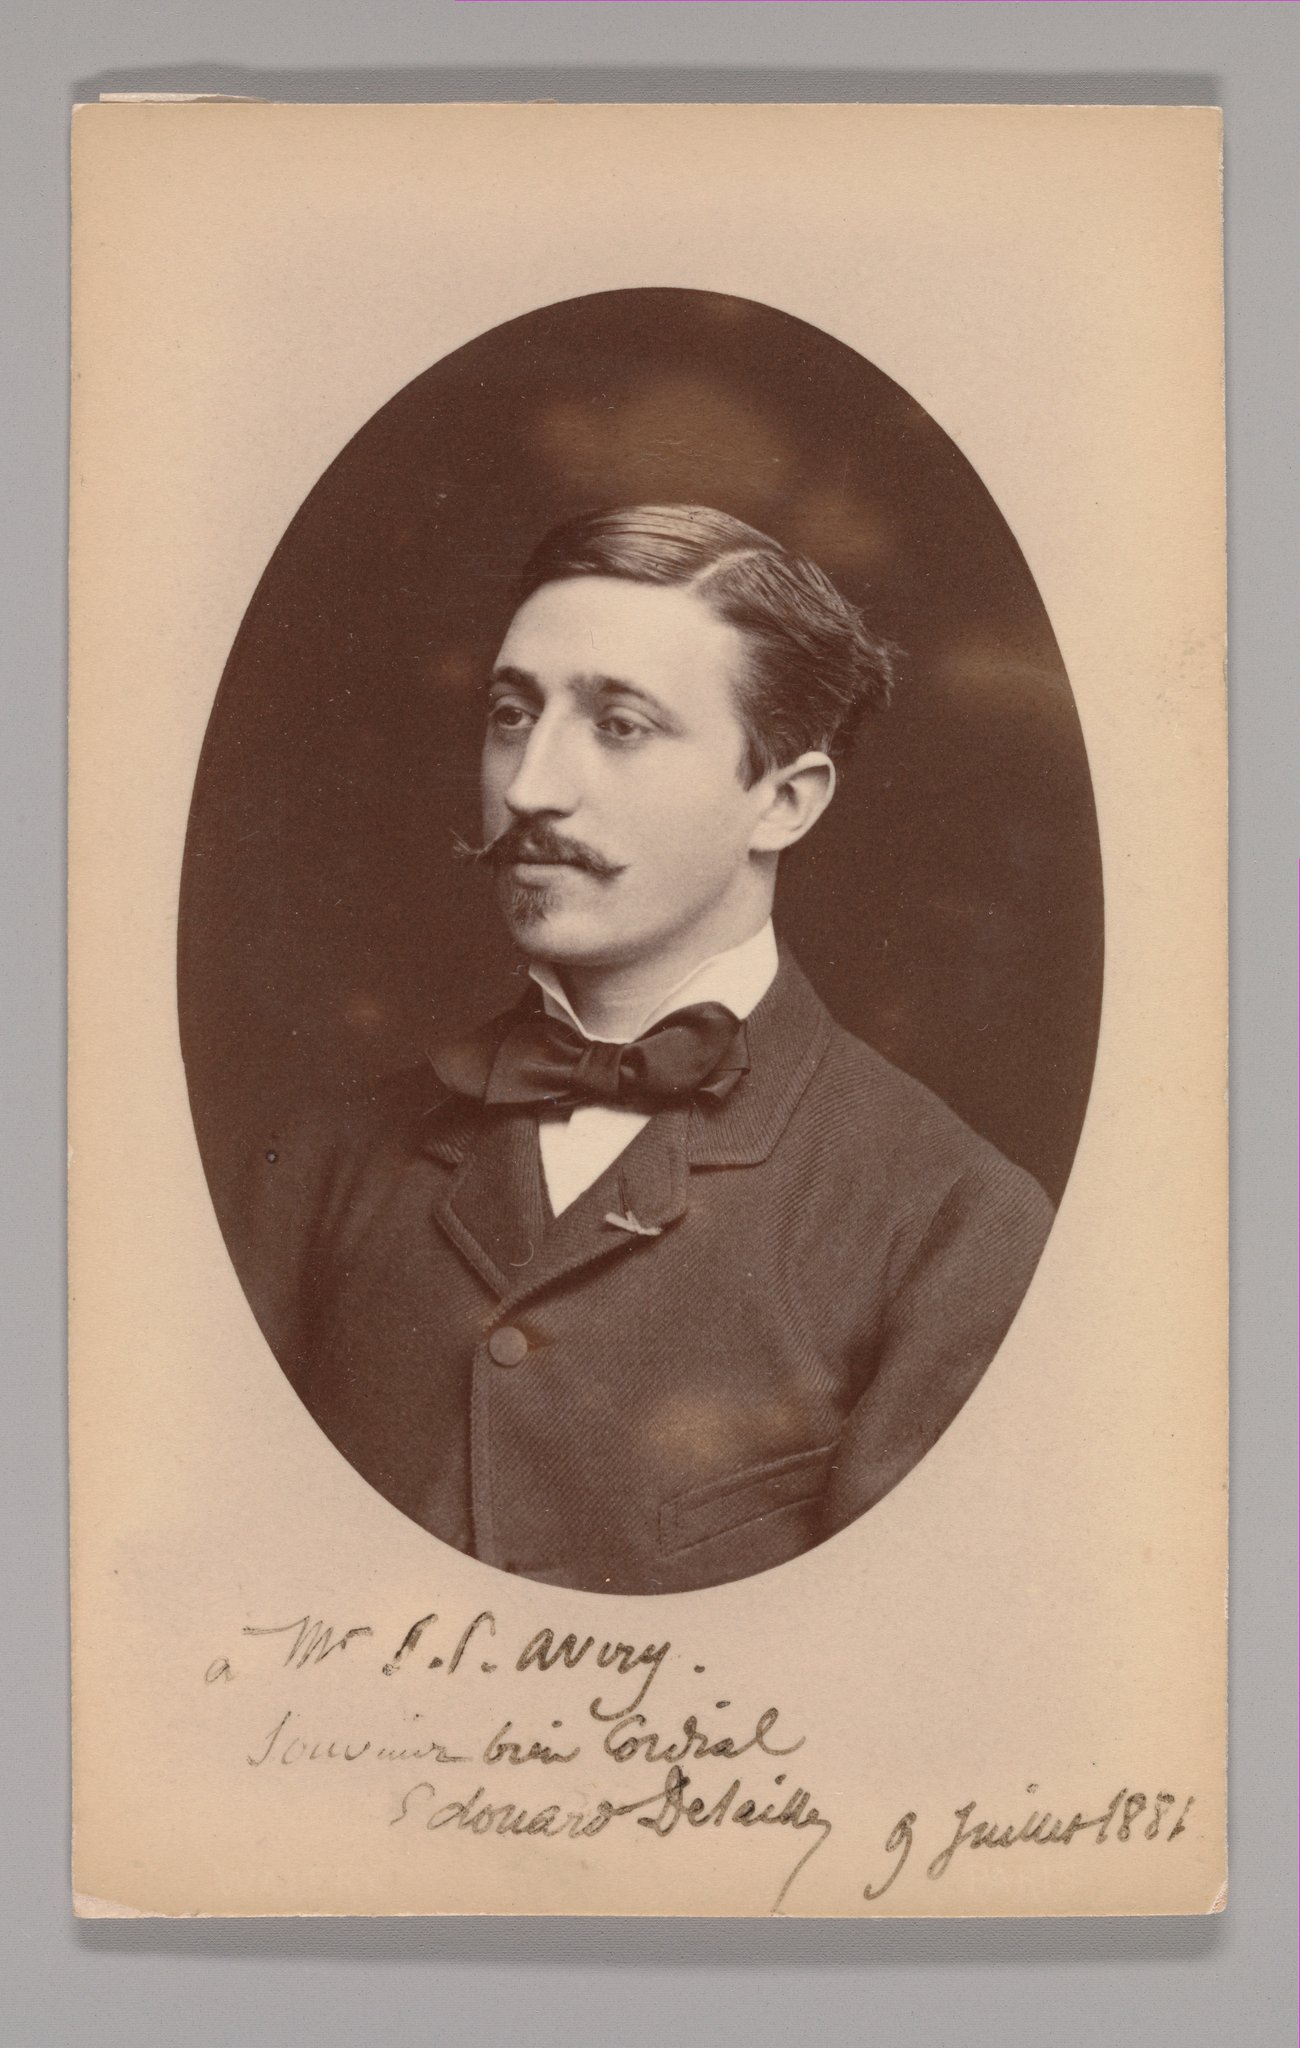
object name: carte de visite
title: [Édouard Detaille]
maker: walery frères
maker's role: photography studio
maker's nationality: french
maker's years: 1860-1879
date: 1870-1879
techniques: albumen silver print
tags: men,portraits